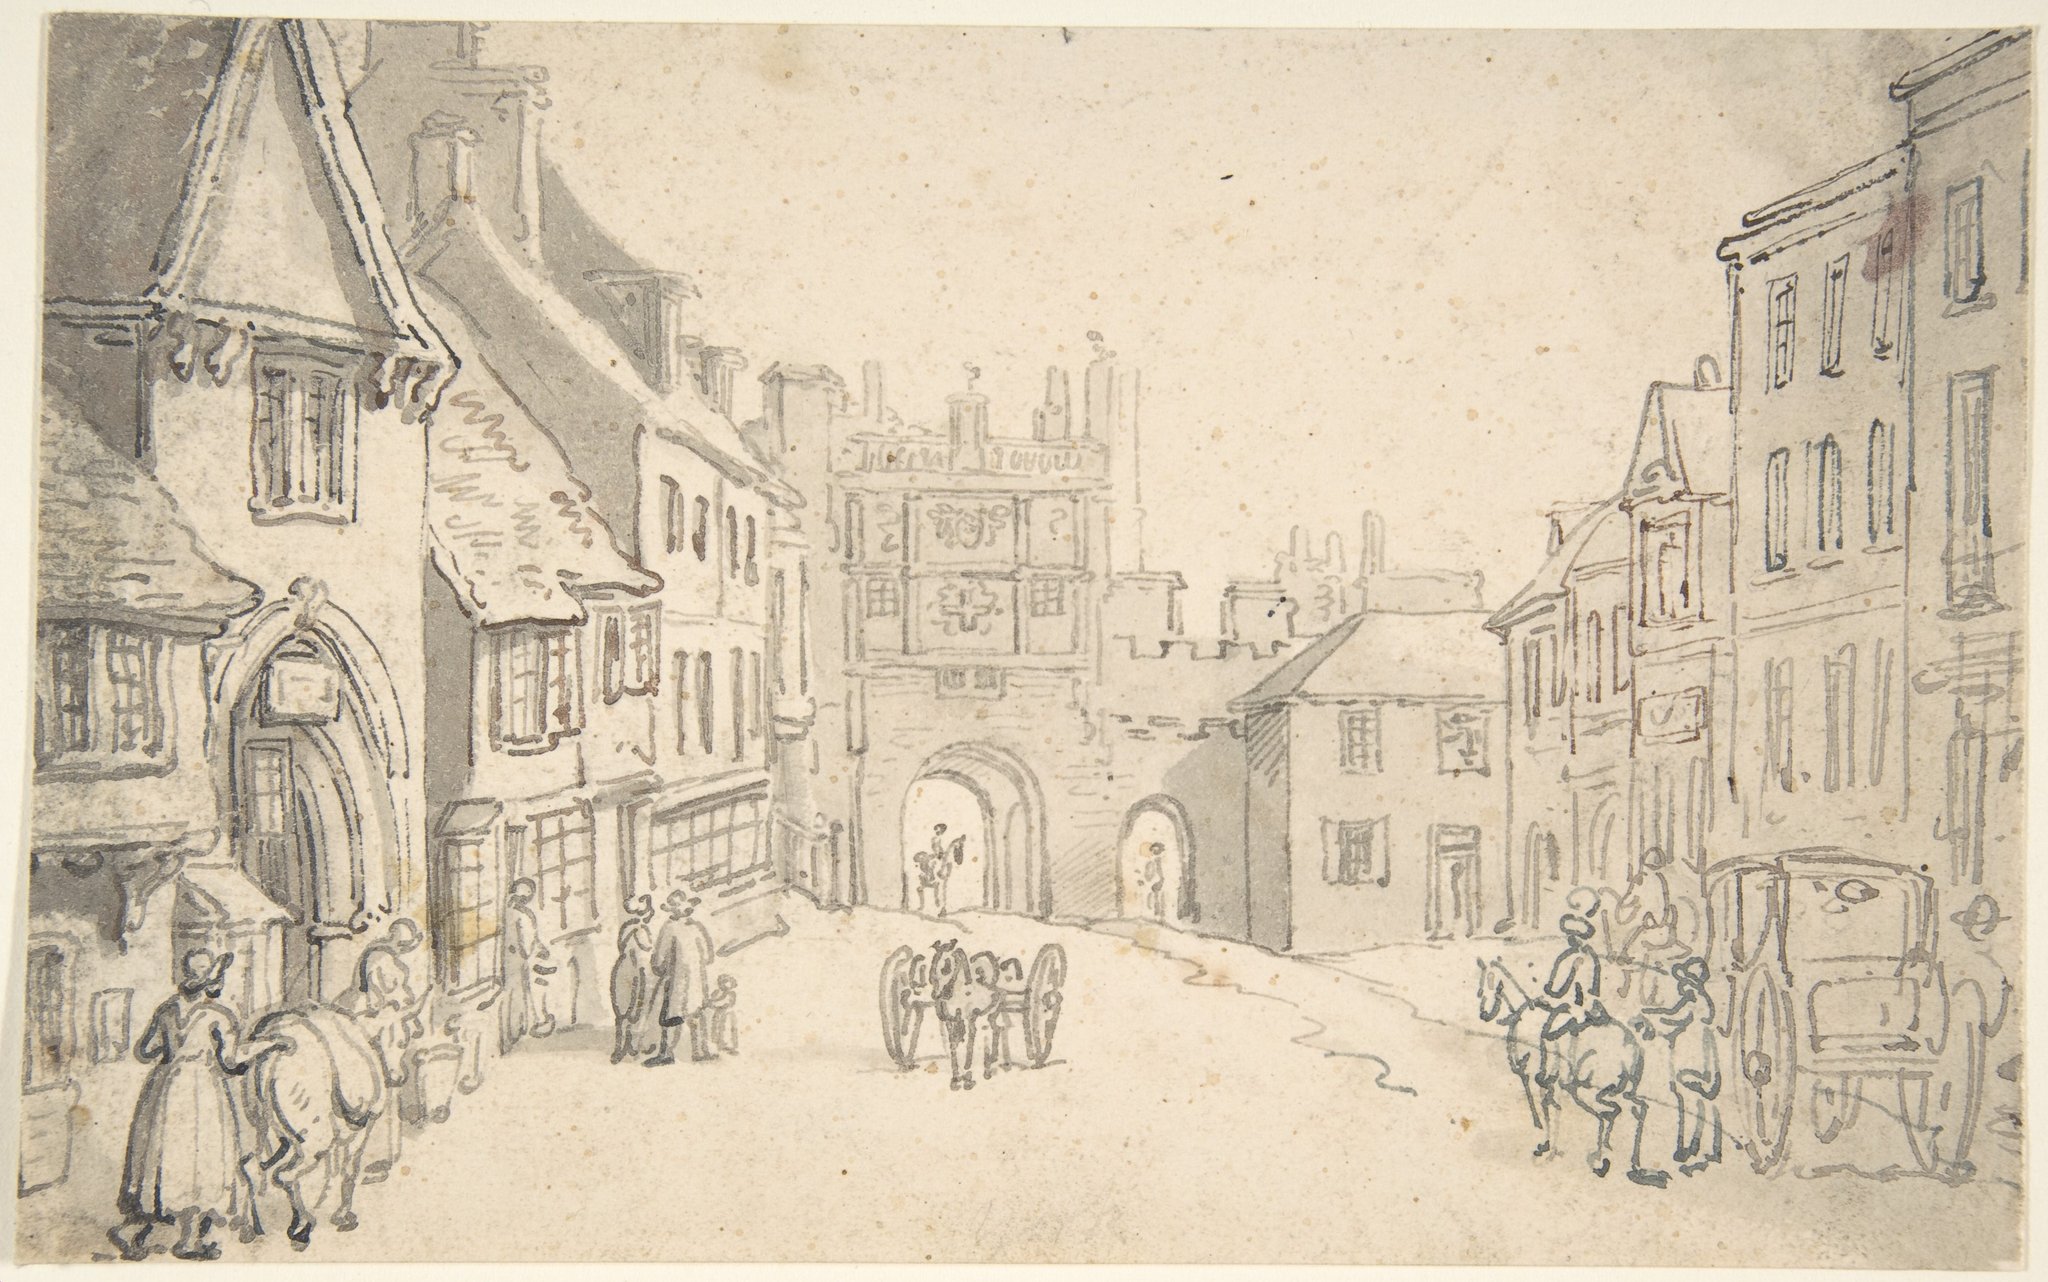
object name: drawing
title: City View with Medieval Gate (perhaps York)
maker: thomas rowlandson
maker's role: artist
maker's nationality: british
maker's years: 1757-1827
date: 1775-1827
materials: ink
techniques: brush, pen, wash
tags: human figures,gates,houses,cities,horses